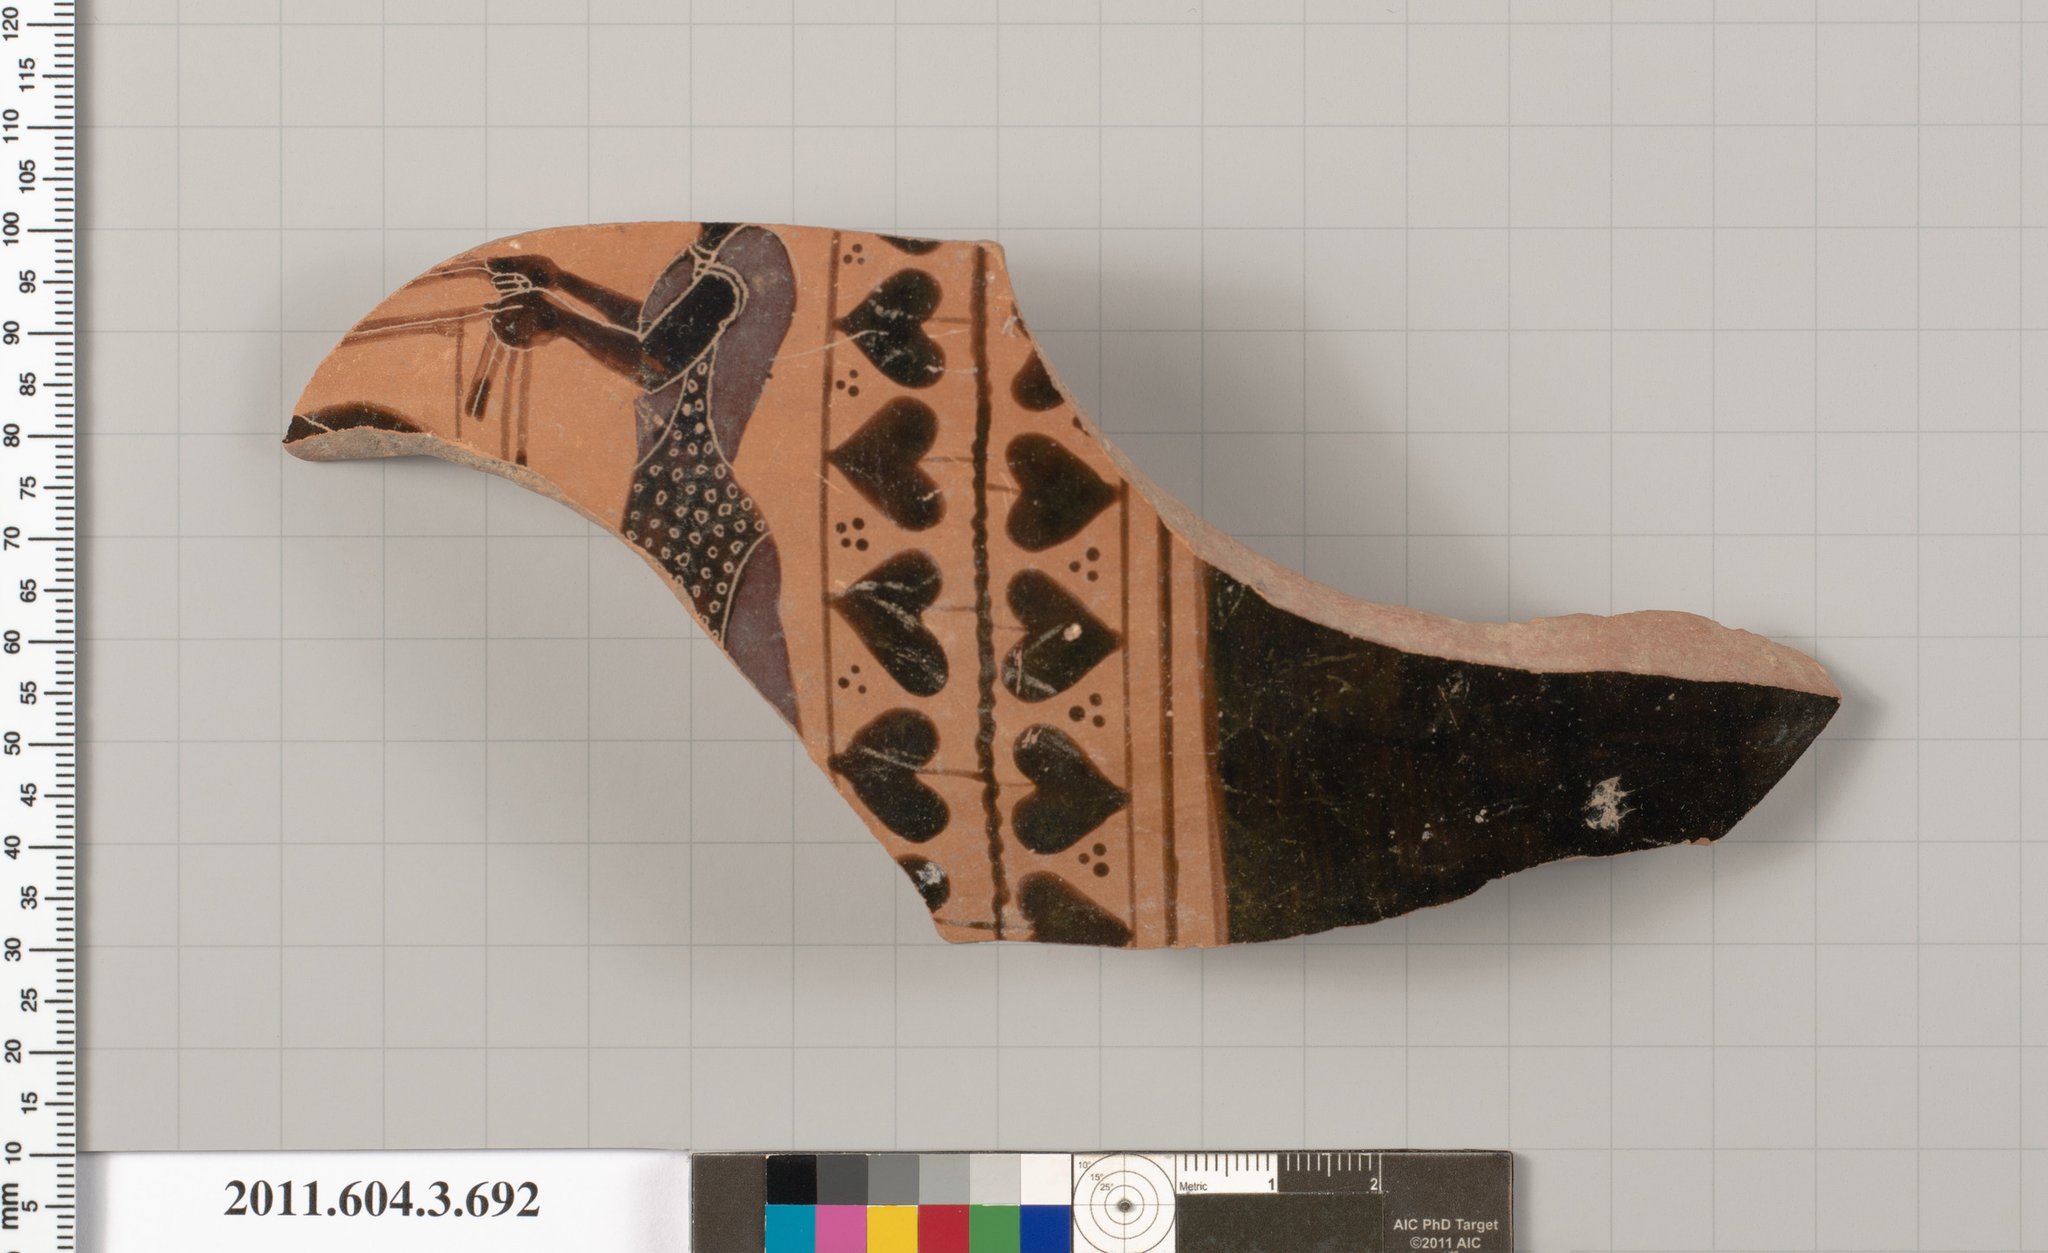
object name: hydria fragment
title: Terracotta fragment of a hydria (water jar)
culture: greek, attic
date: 567-535 BCE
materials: terracotta